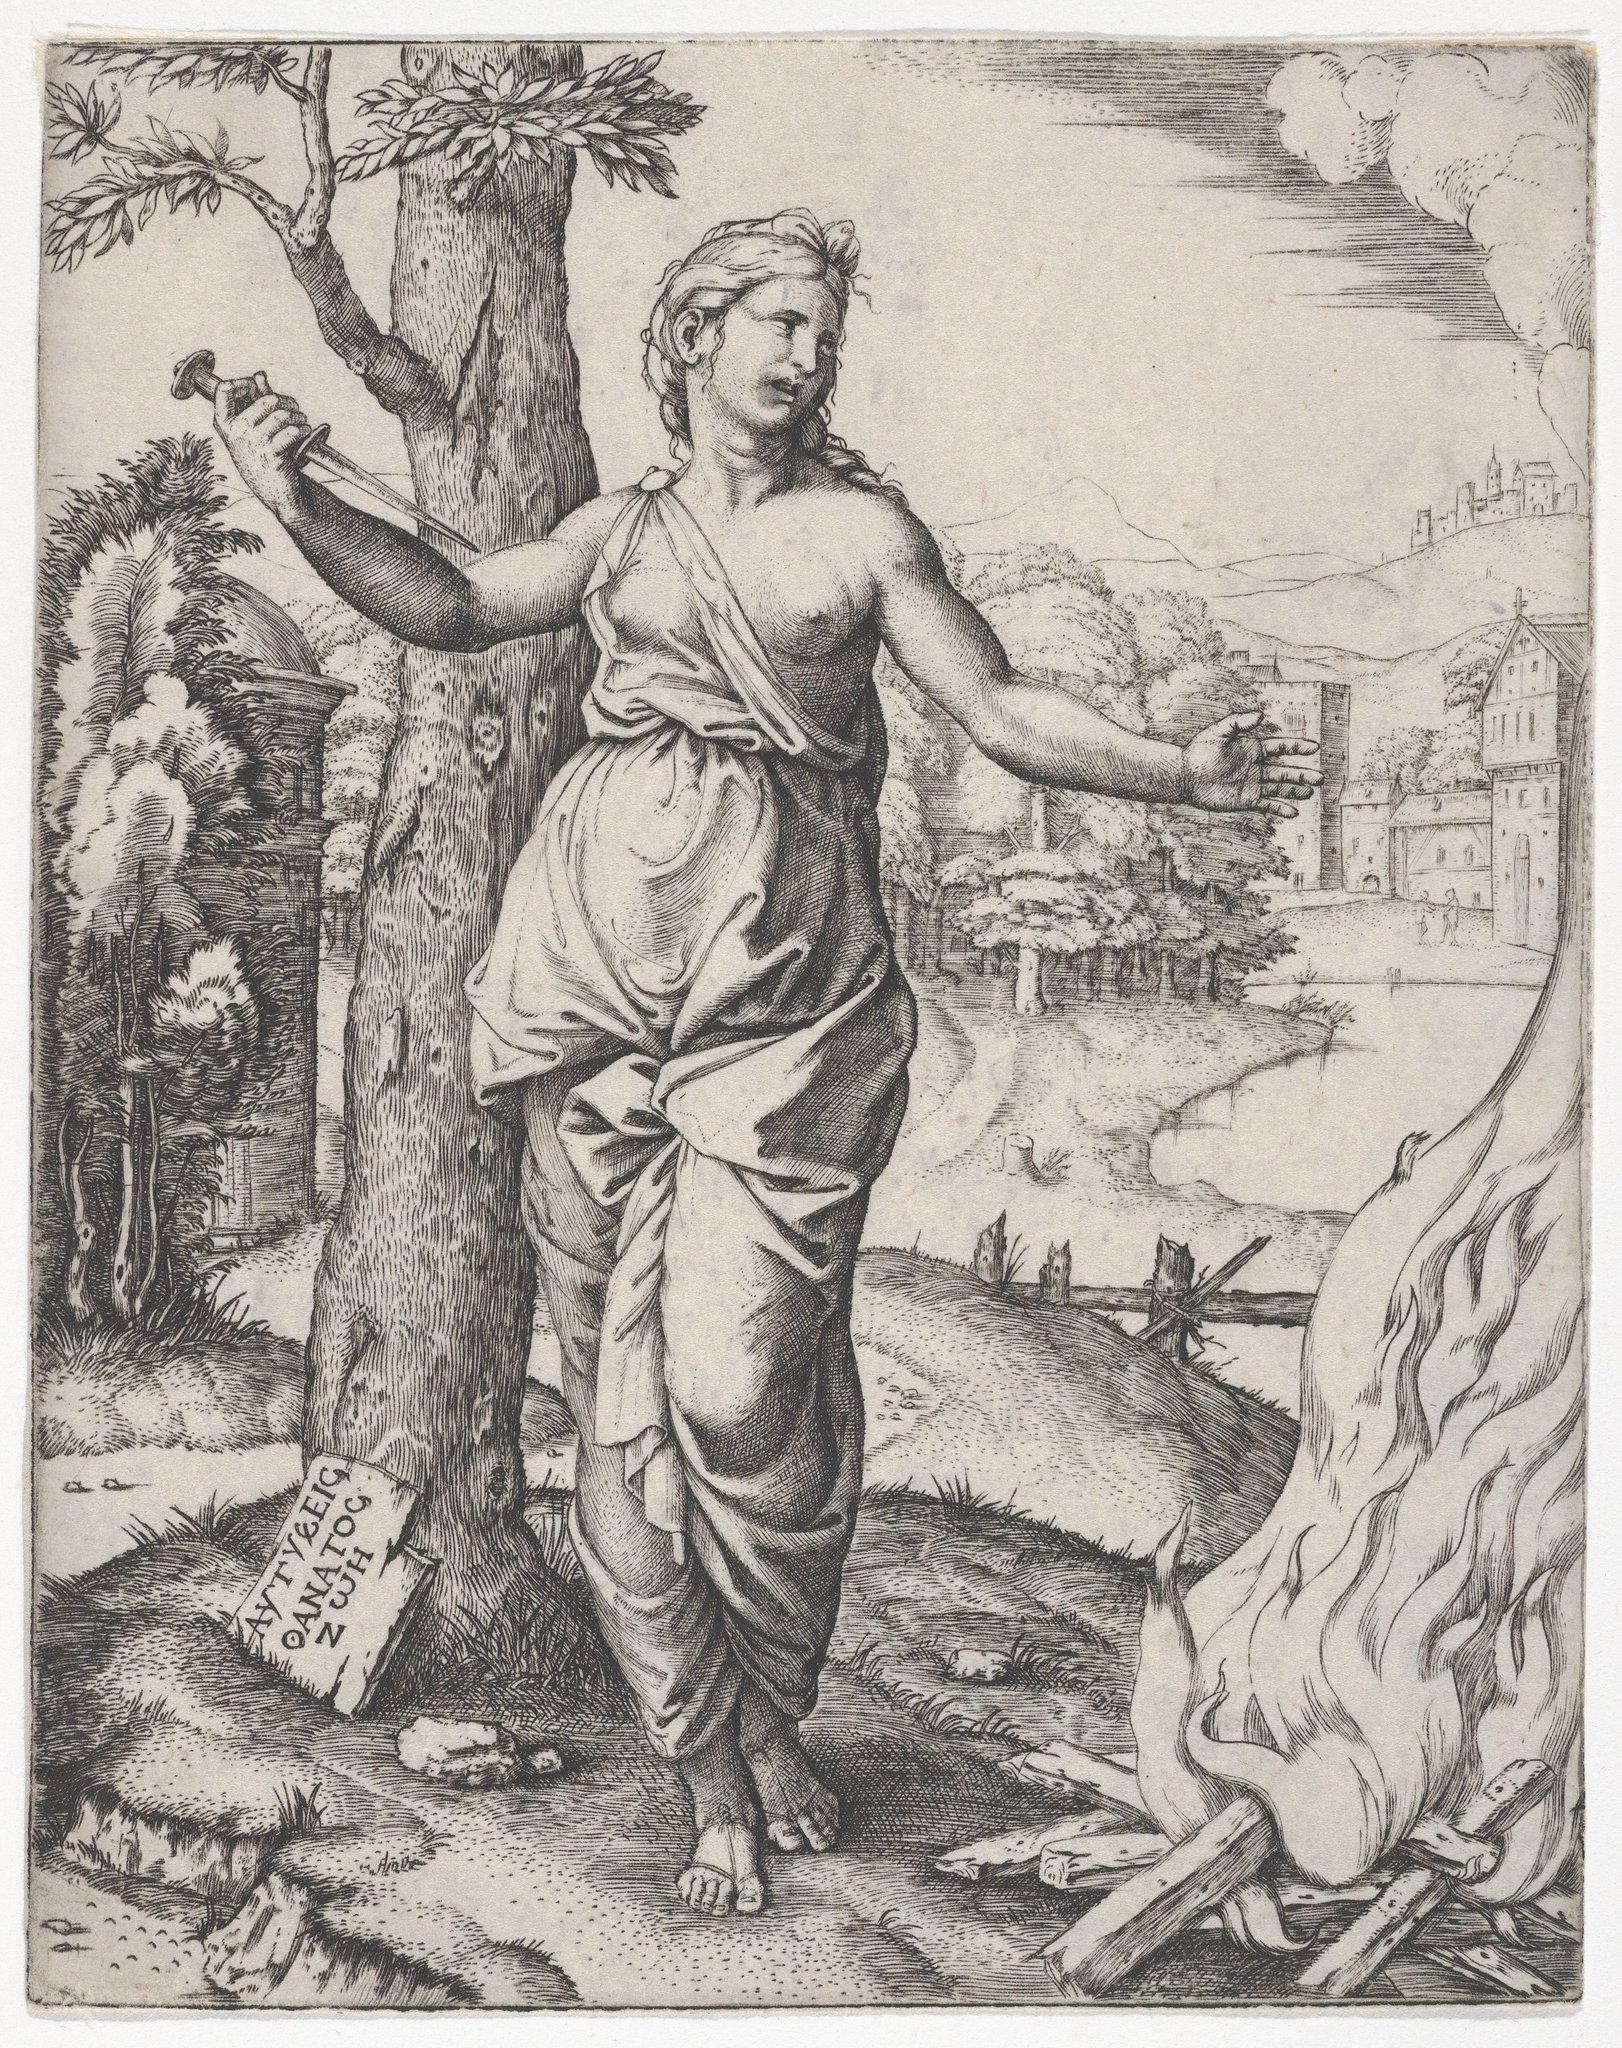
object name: print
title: Dido holding a dagger in her right hand, left arm outstretched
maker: marcantonio raimondi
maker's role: artist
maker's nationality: italian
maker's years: 1475-1534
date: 1510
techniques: engraving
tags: daggers,women